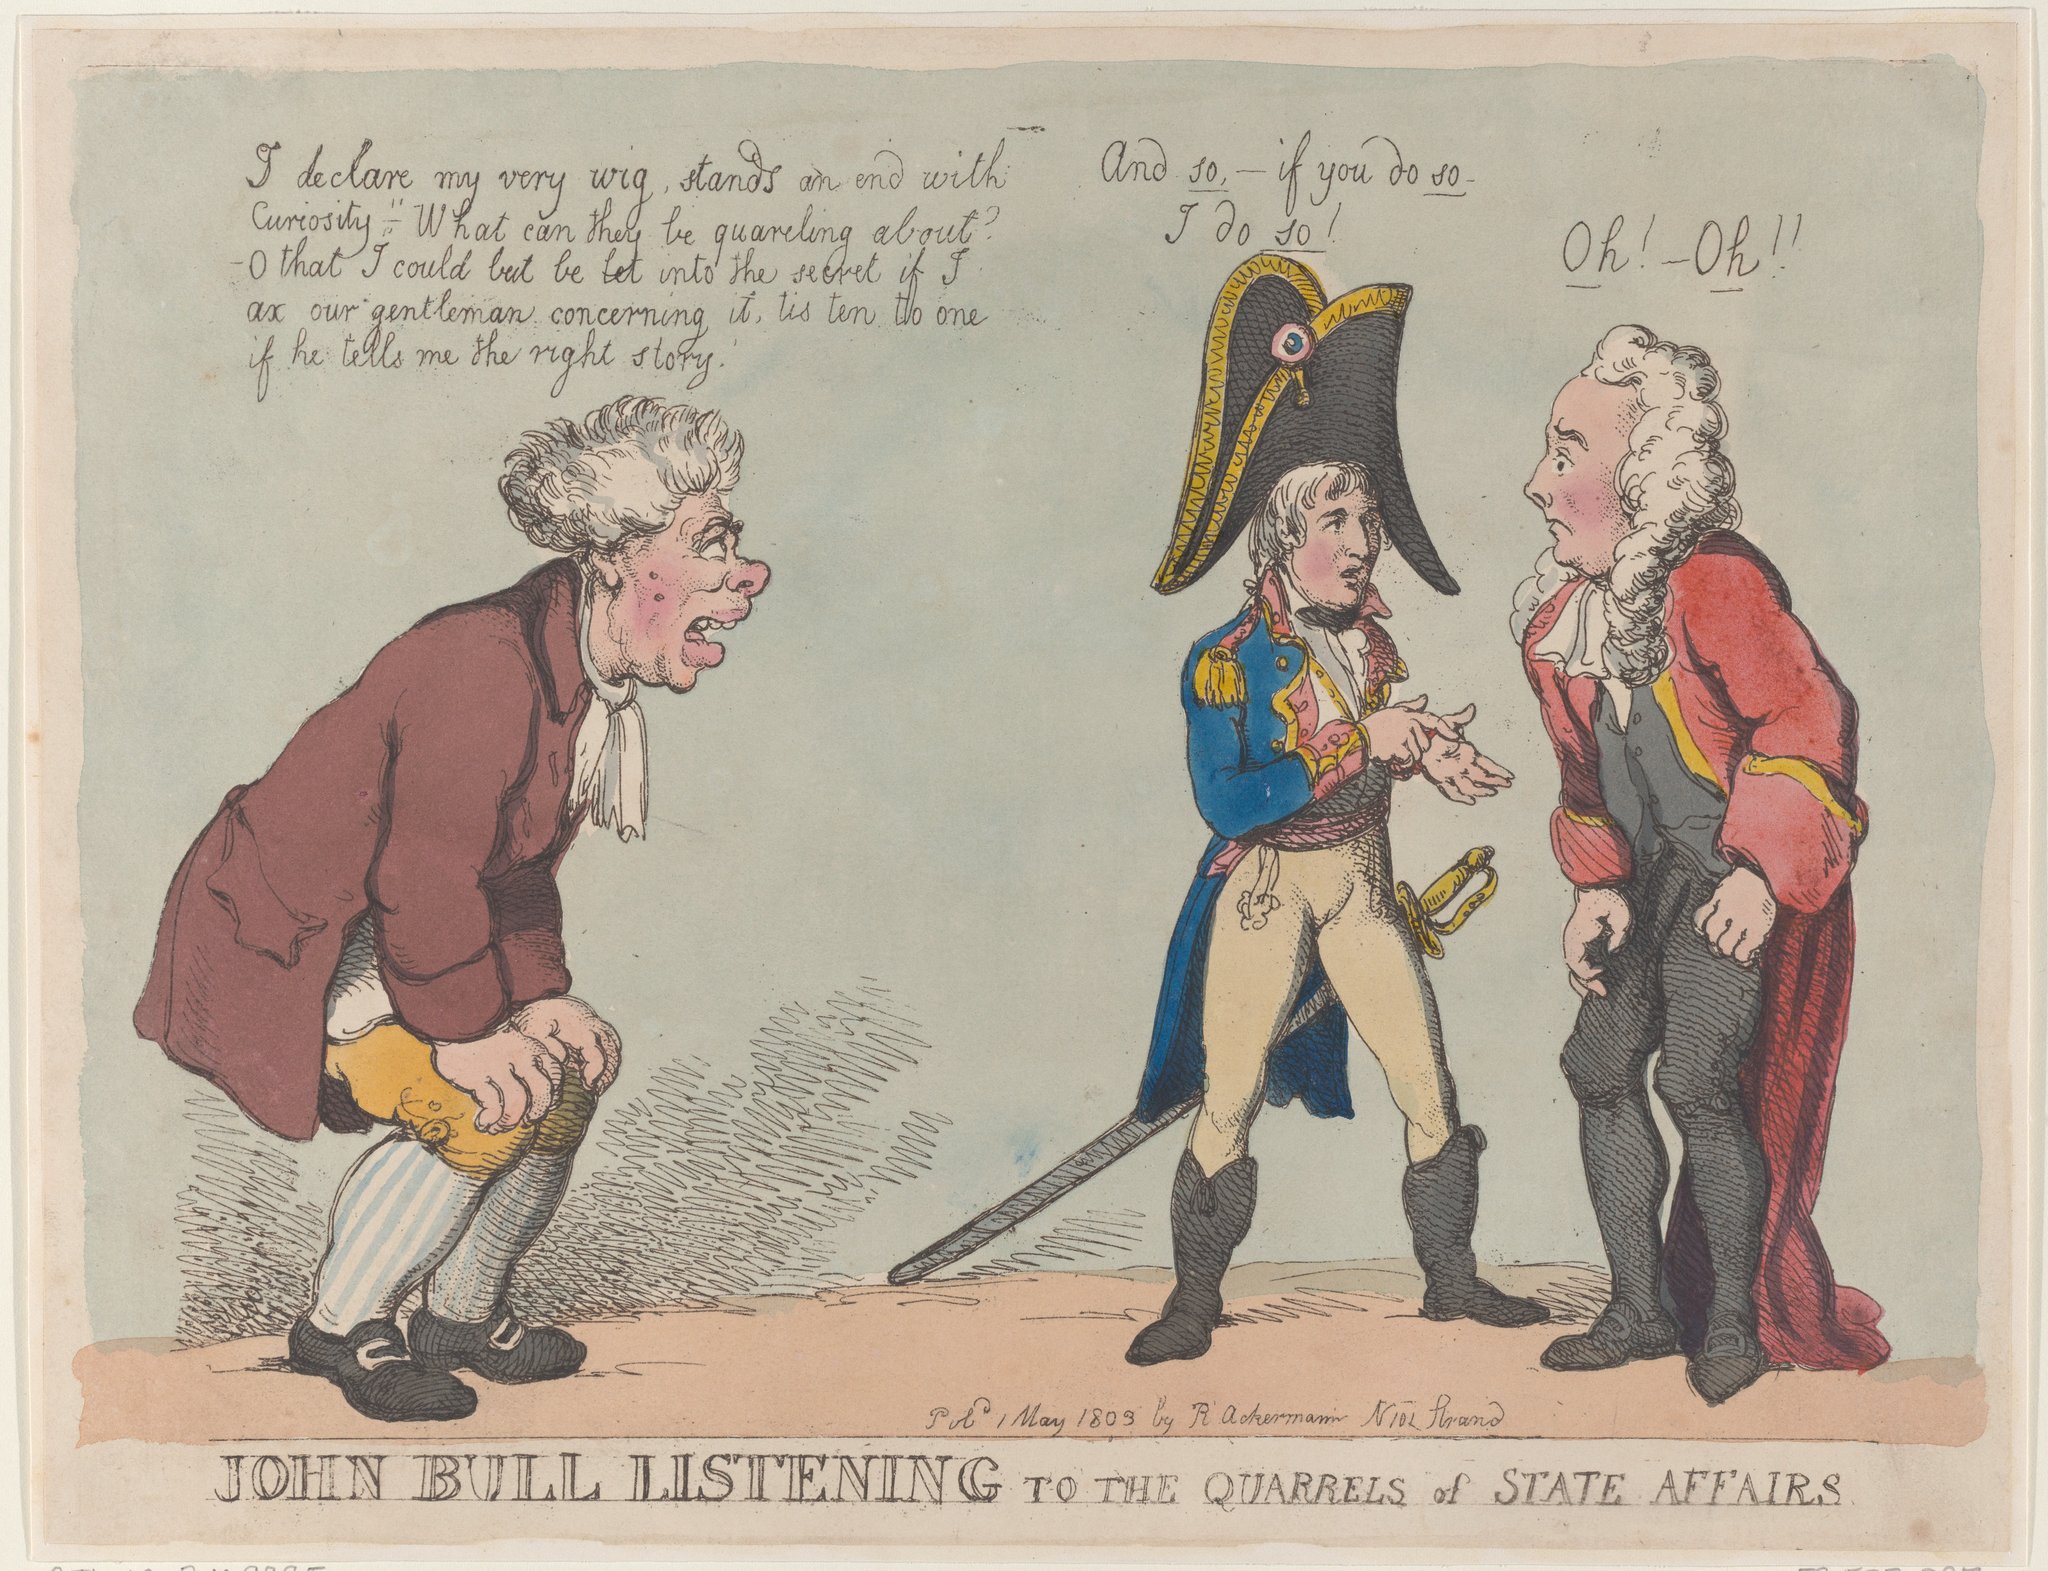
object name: print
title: John Bull Listening to the Quarrels of State Affairs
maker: thomas rowlandson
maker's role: artist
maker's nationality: british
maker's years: 1757-1827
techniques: etching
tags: satire,napoleon i,men,politics